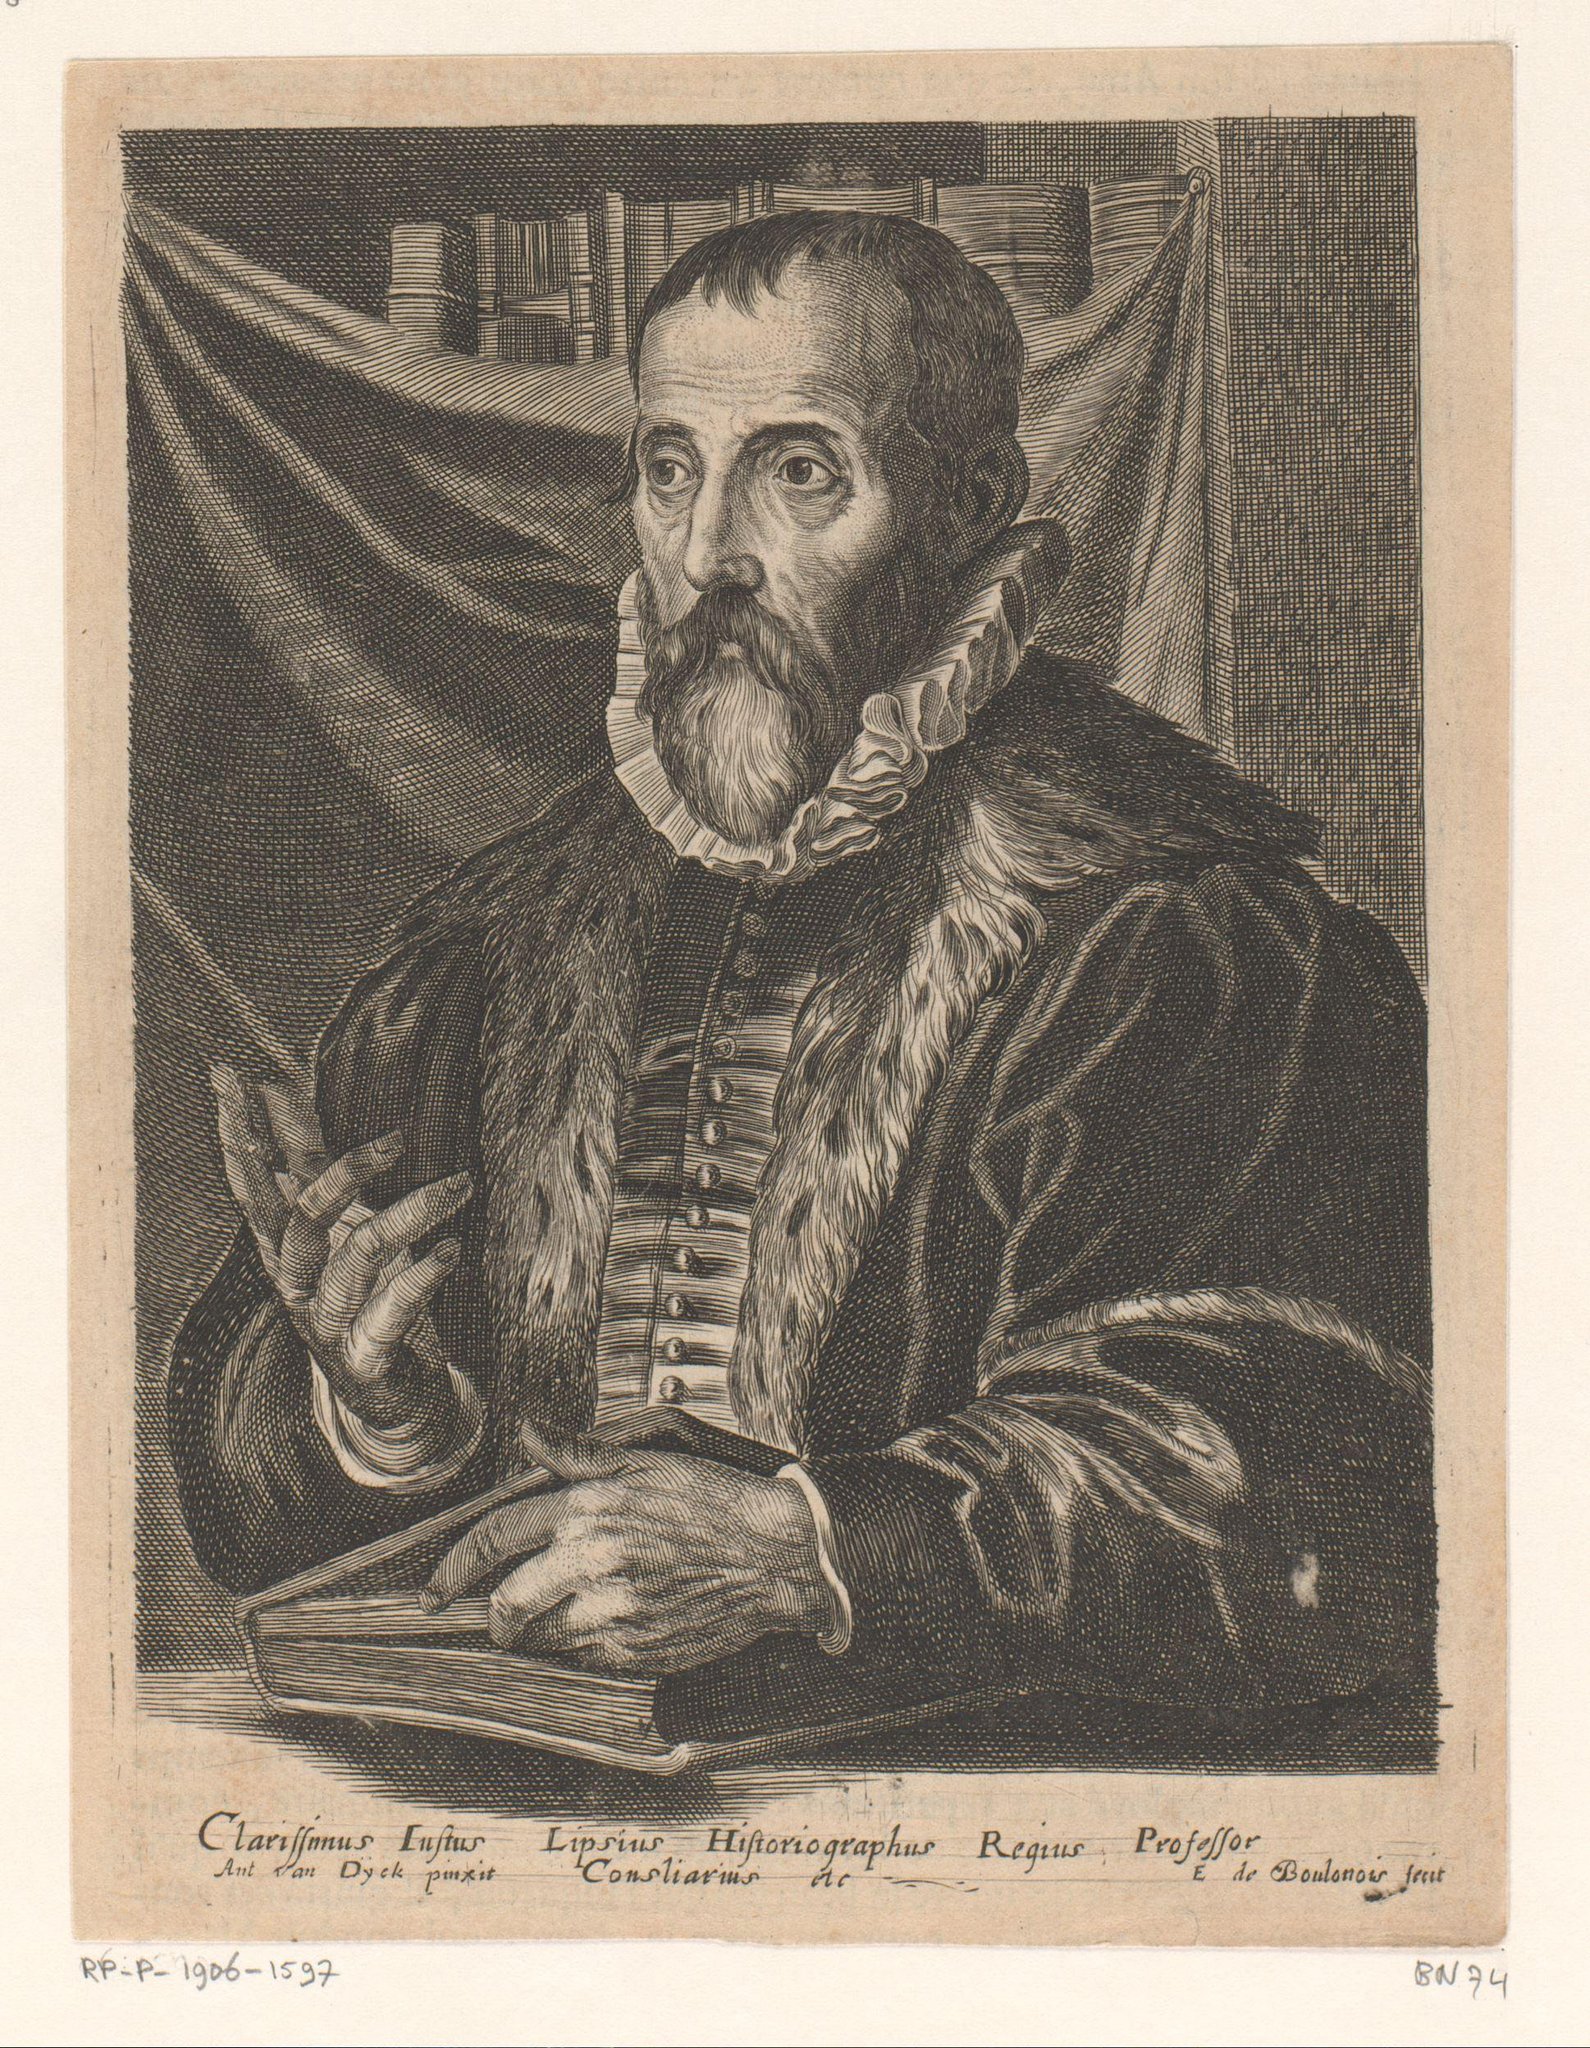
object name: book illustration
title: Portret van Justus Lipsius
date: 1682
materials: paper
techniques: engraving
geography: brussels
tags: louvain, justus lipsius, scholar, philosopher, historical persons, professor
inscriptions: collector's mark: Lugt 2228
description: Prent uit: Bullert, Isaac. Académie des Sciences et Arts contenant les vies et éloges his. des hommes illustres qui ont excellé en ces professions depuis environ quatre siècles. Brussel: Foppens, François, 1682. Het boek werd in 1682 eveneens in Amsterdam uitgegeven door de erfgenamen van Daniel Elzevier. Deze portretten dienen ter illustratie van de biografie van een kunstenaar of geleerde. De meeste portretten werden door Nicolas de Larmessin vervaardigd (162), 93 door De Boulonois en een derde door ongeïdentificeerde prentmakers. Dit betreft een illustratie op p. 193, deel II.